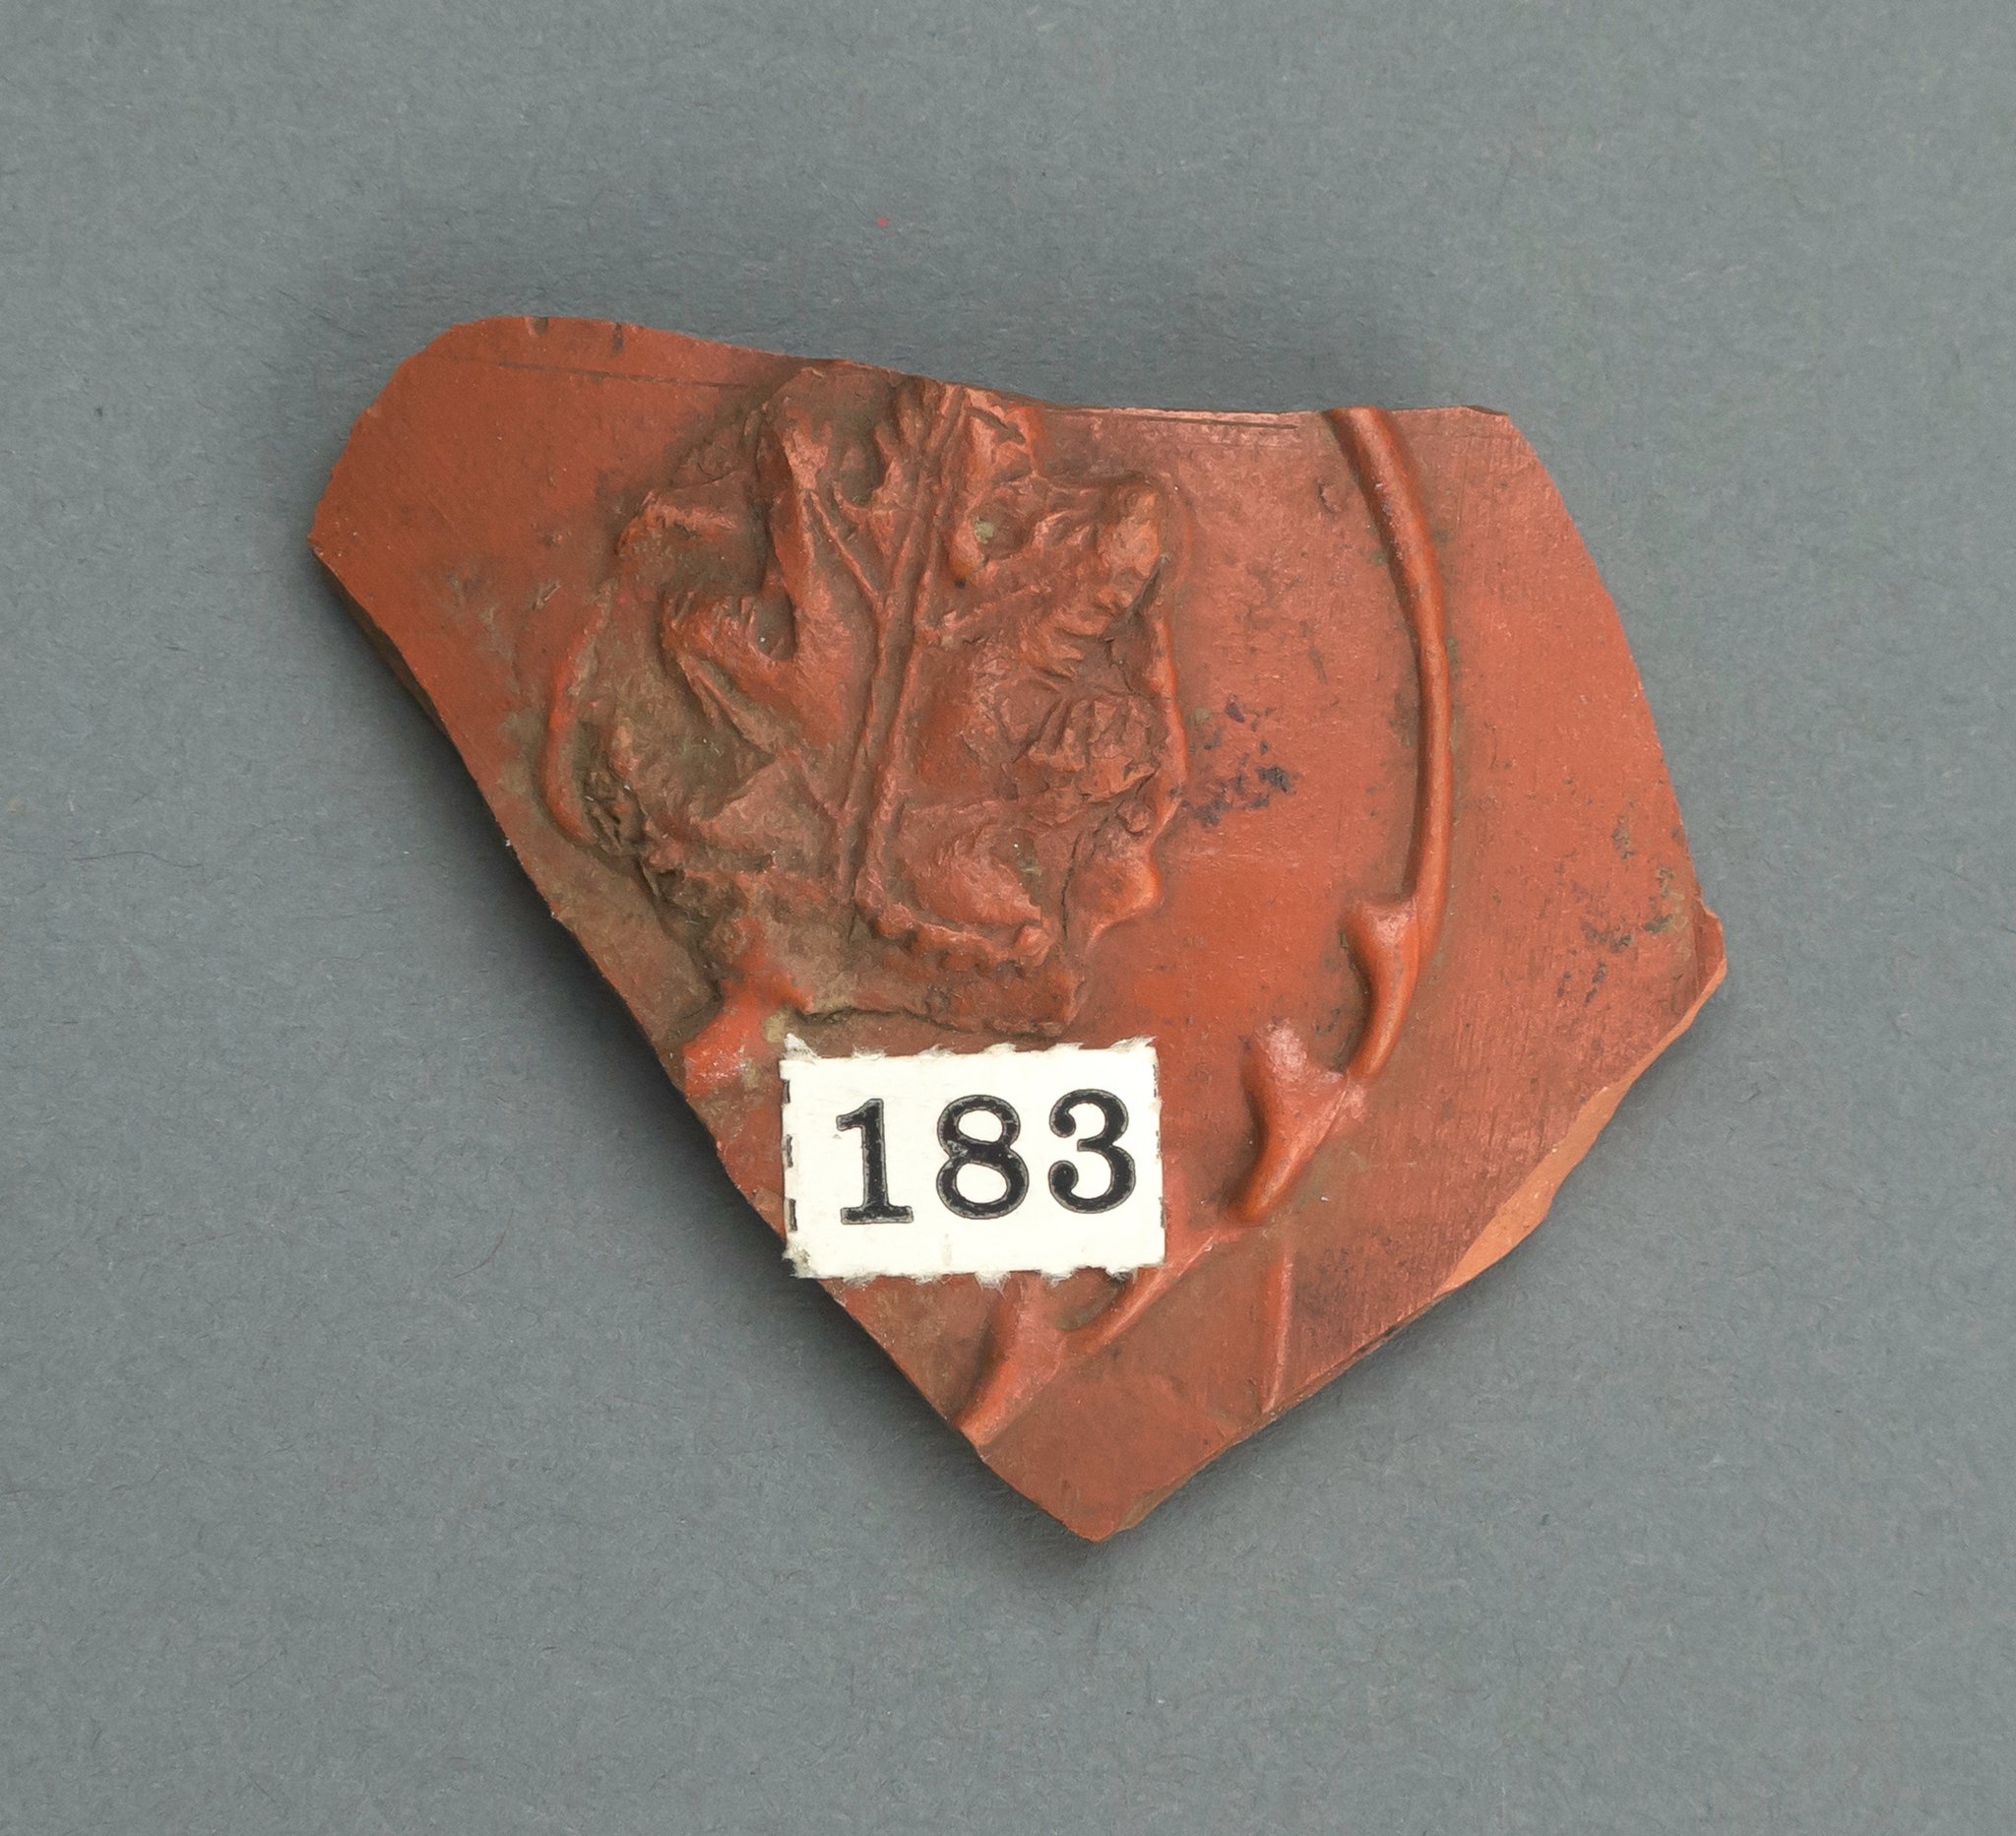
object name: vase fragment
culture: roman, gaul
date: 120 BCE-300 CE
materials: terracotta